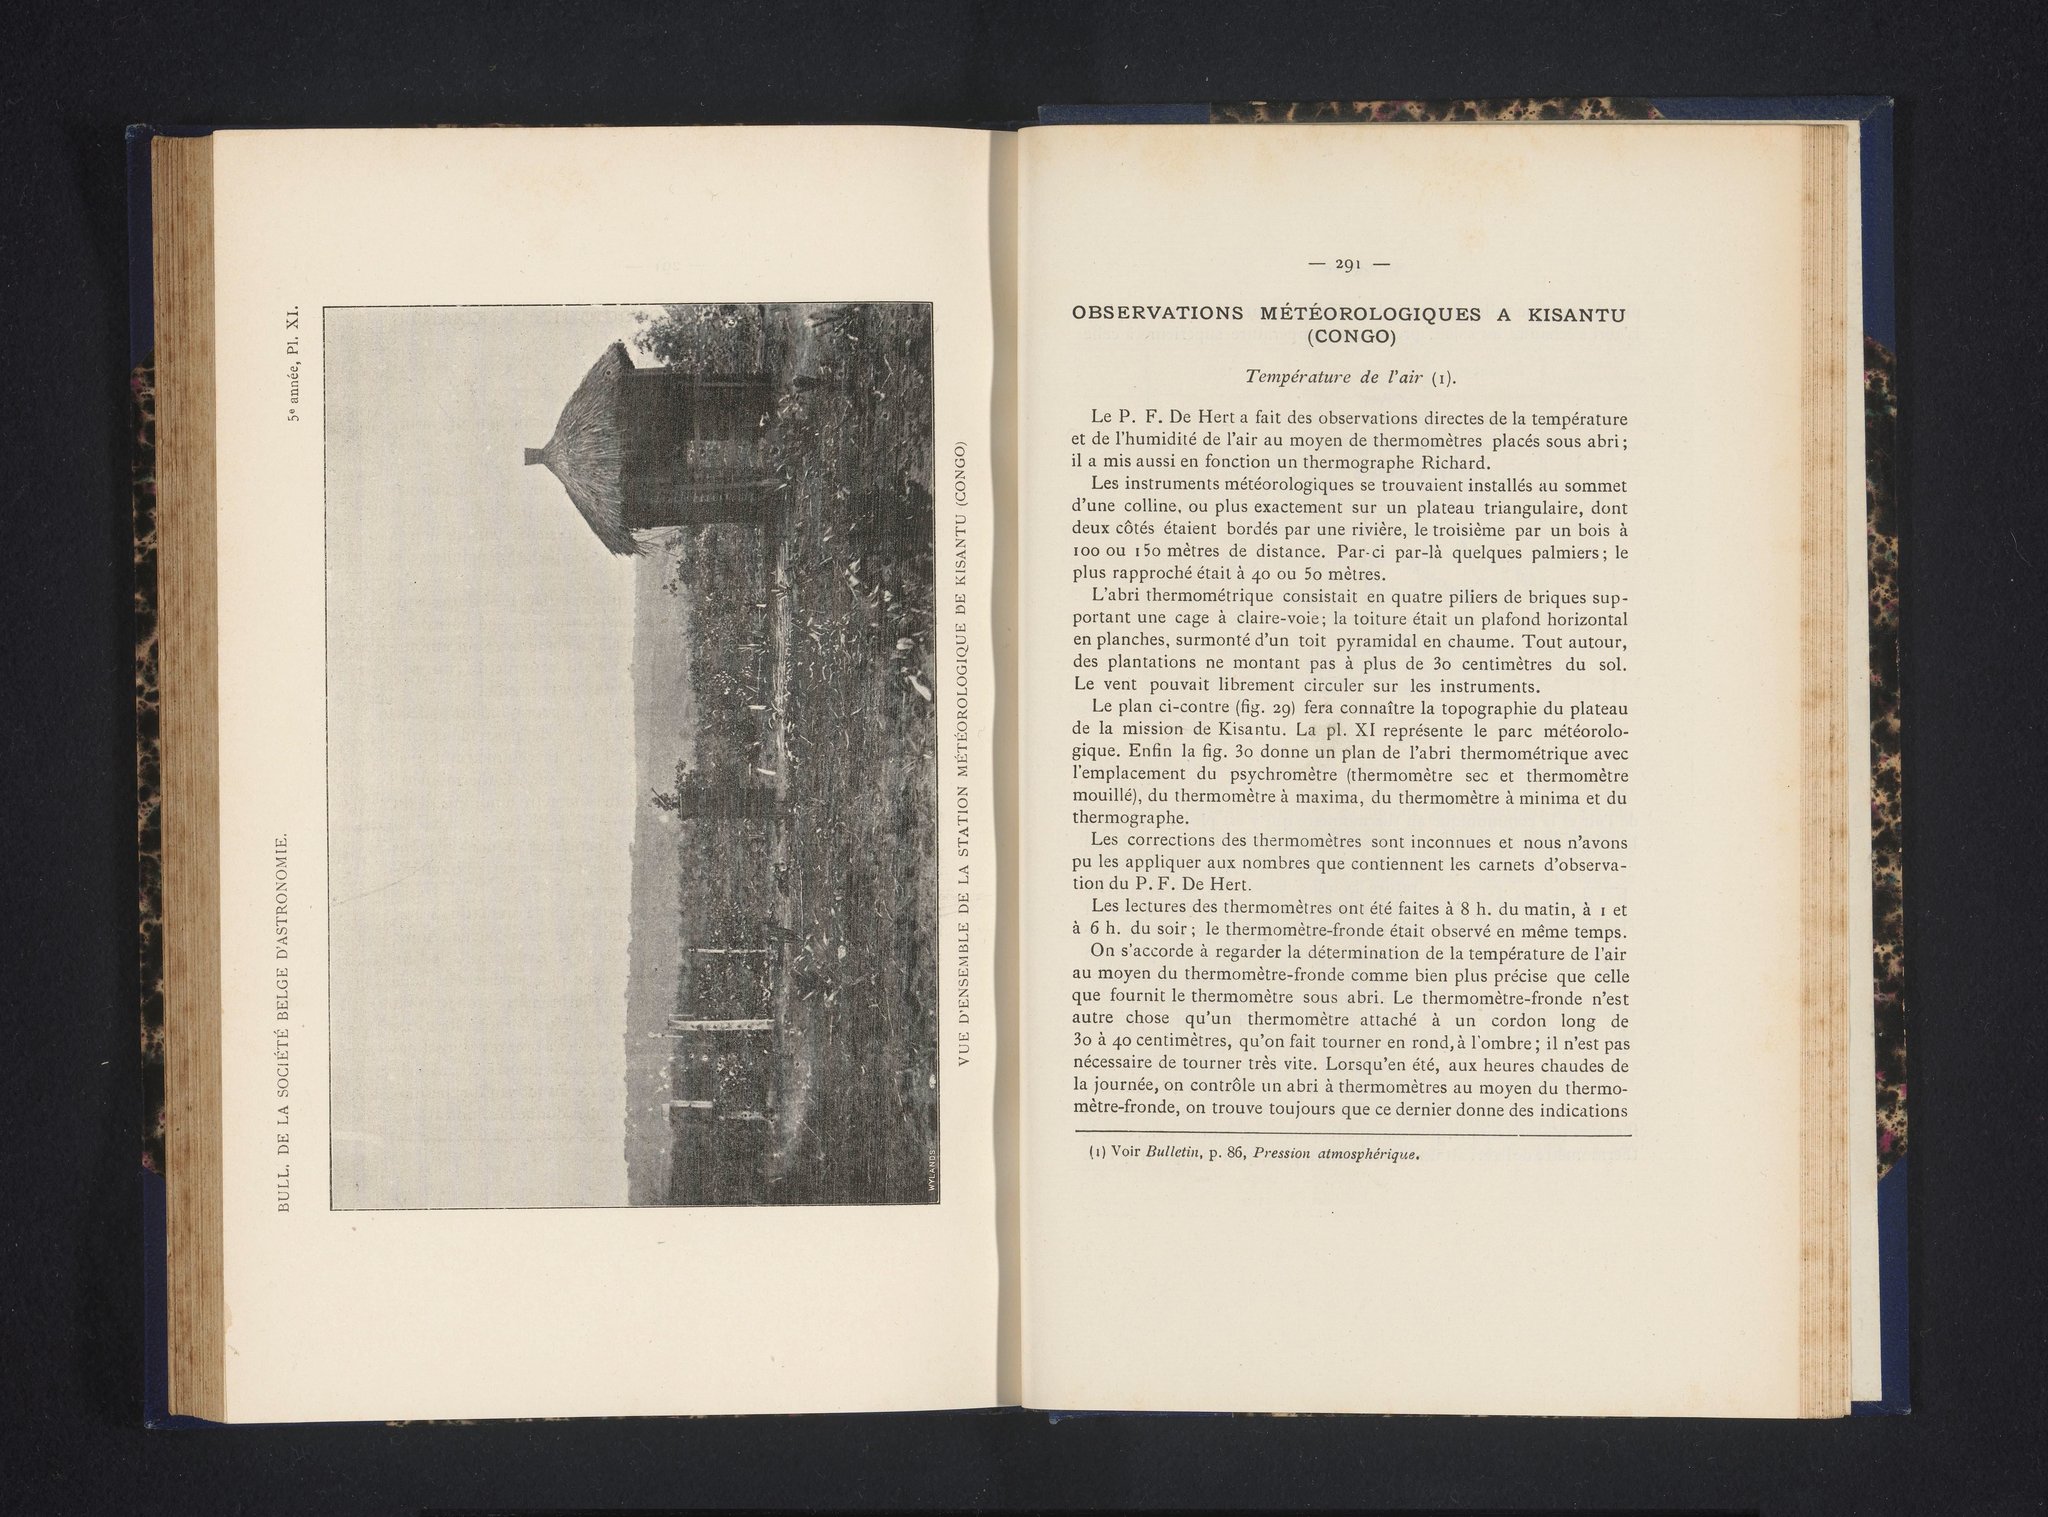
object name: page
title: Gezicht op een meteorologisch station in Kisantu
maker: Anonymous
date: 1895-1900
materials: paper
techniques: autotype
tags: meteorology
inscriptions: inscription: ‘5e année. Pl. XI.’